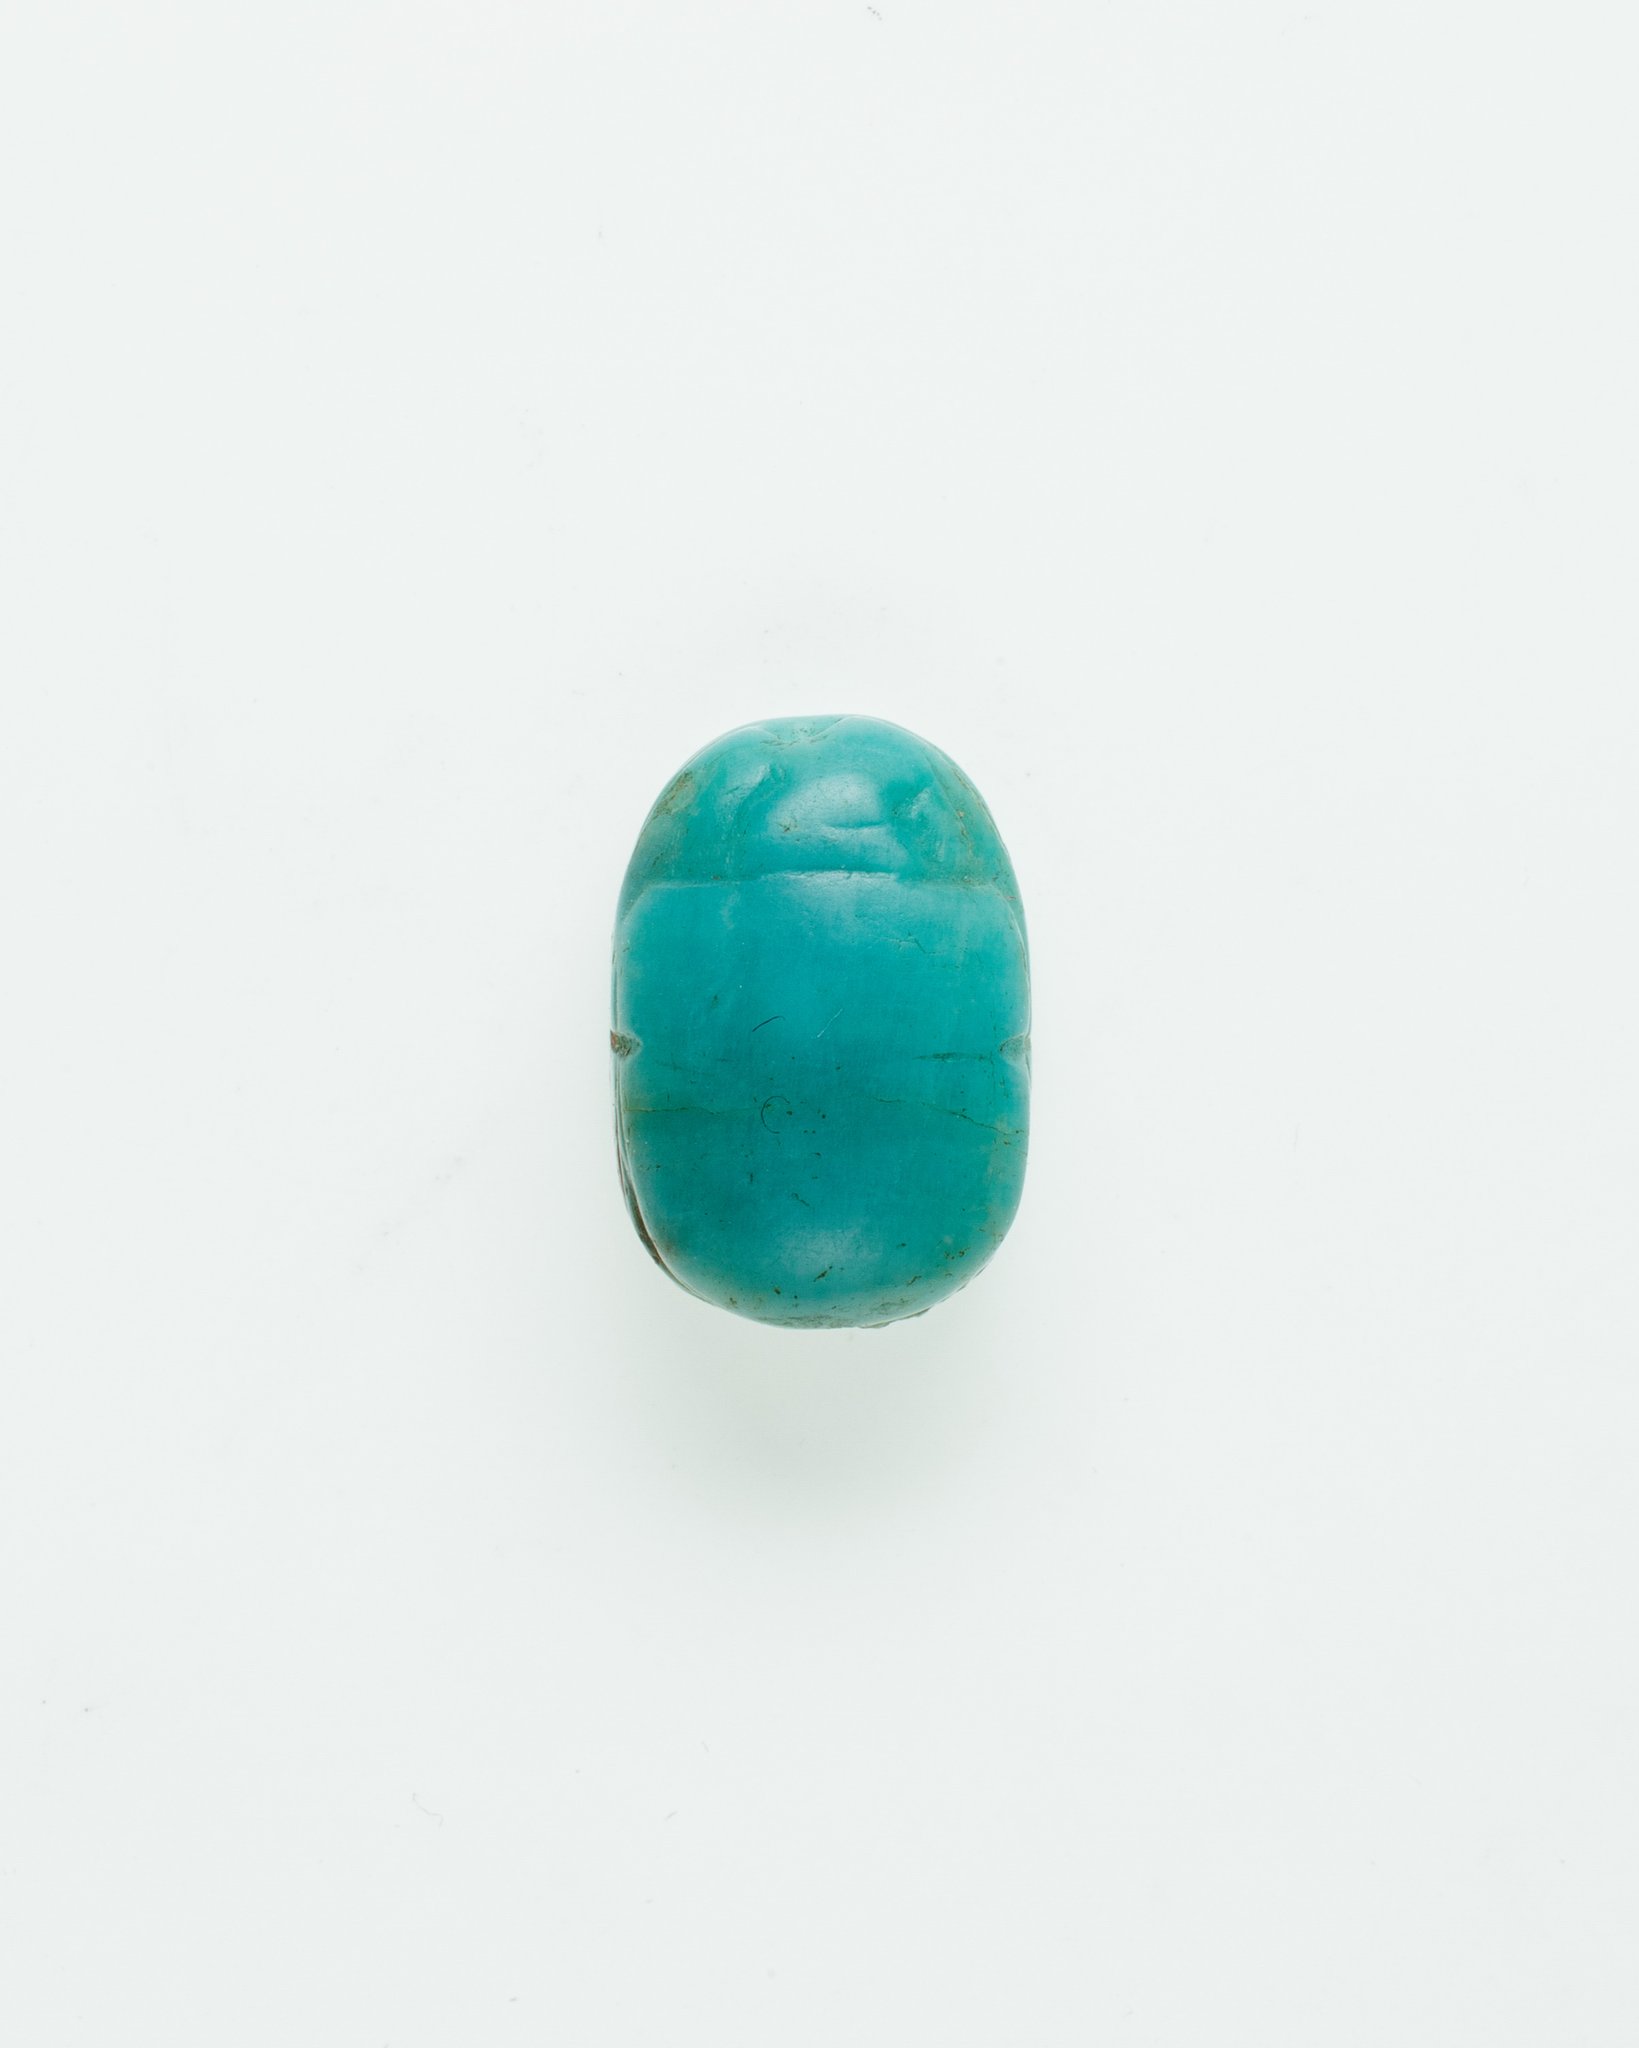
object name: scarab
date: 1850-1700 BCE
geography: egypt